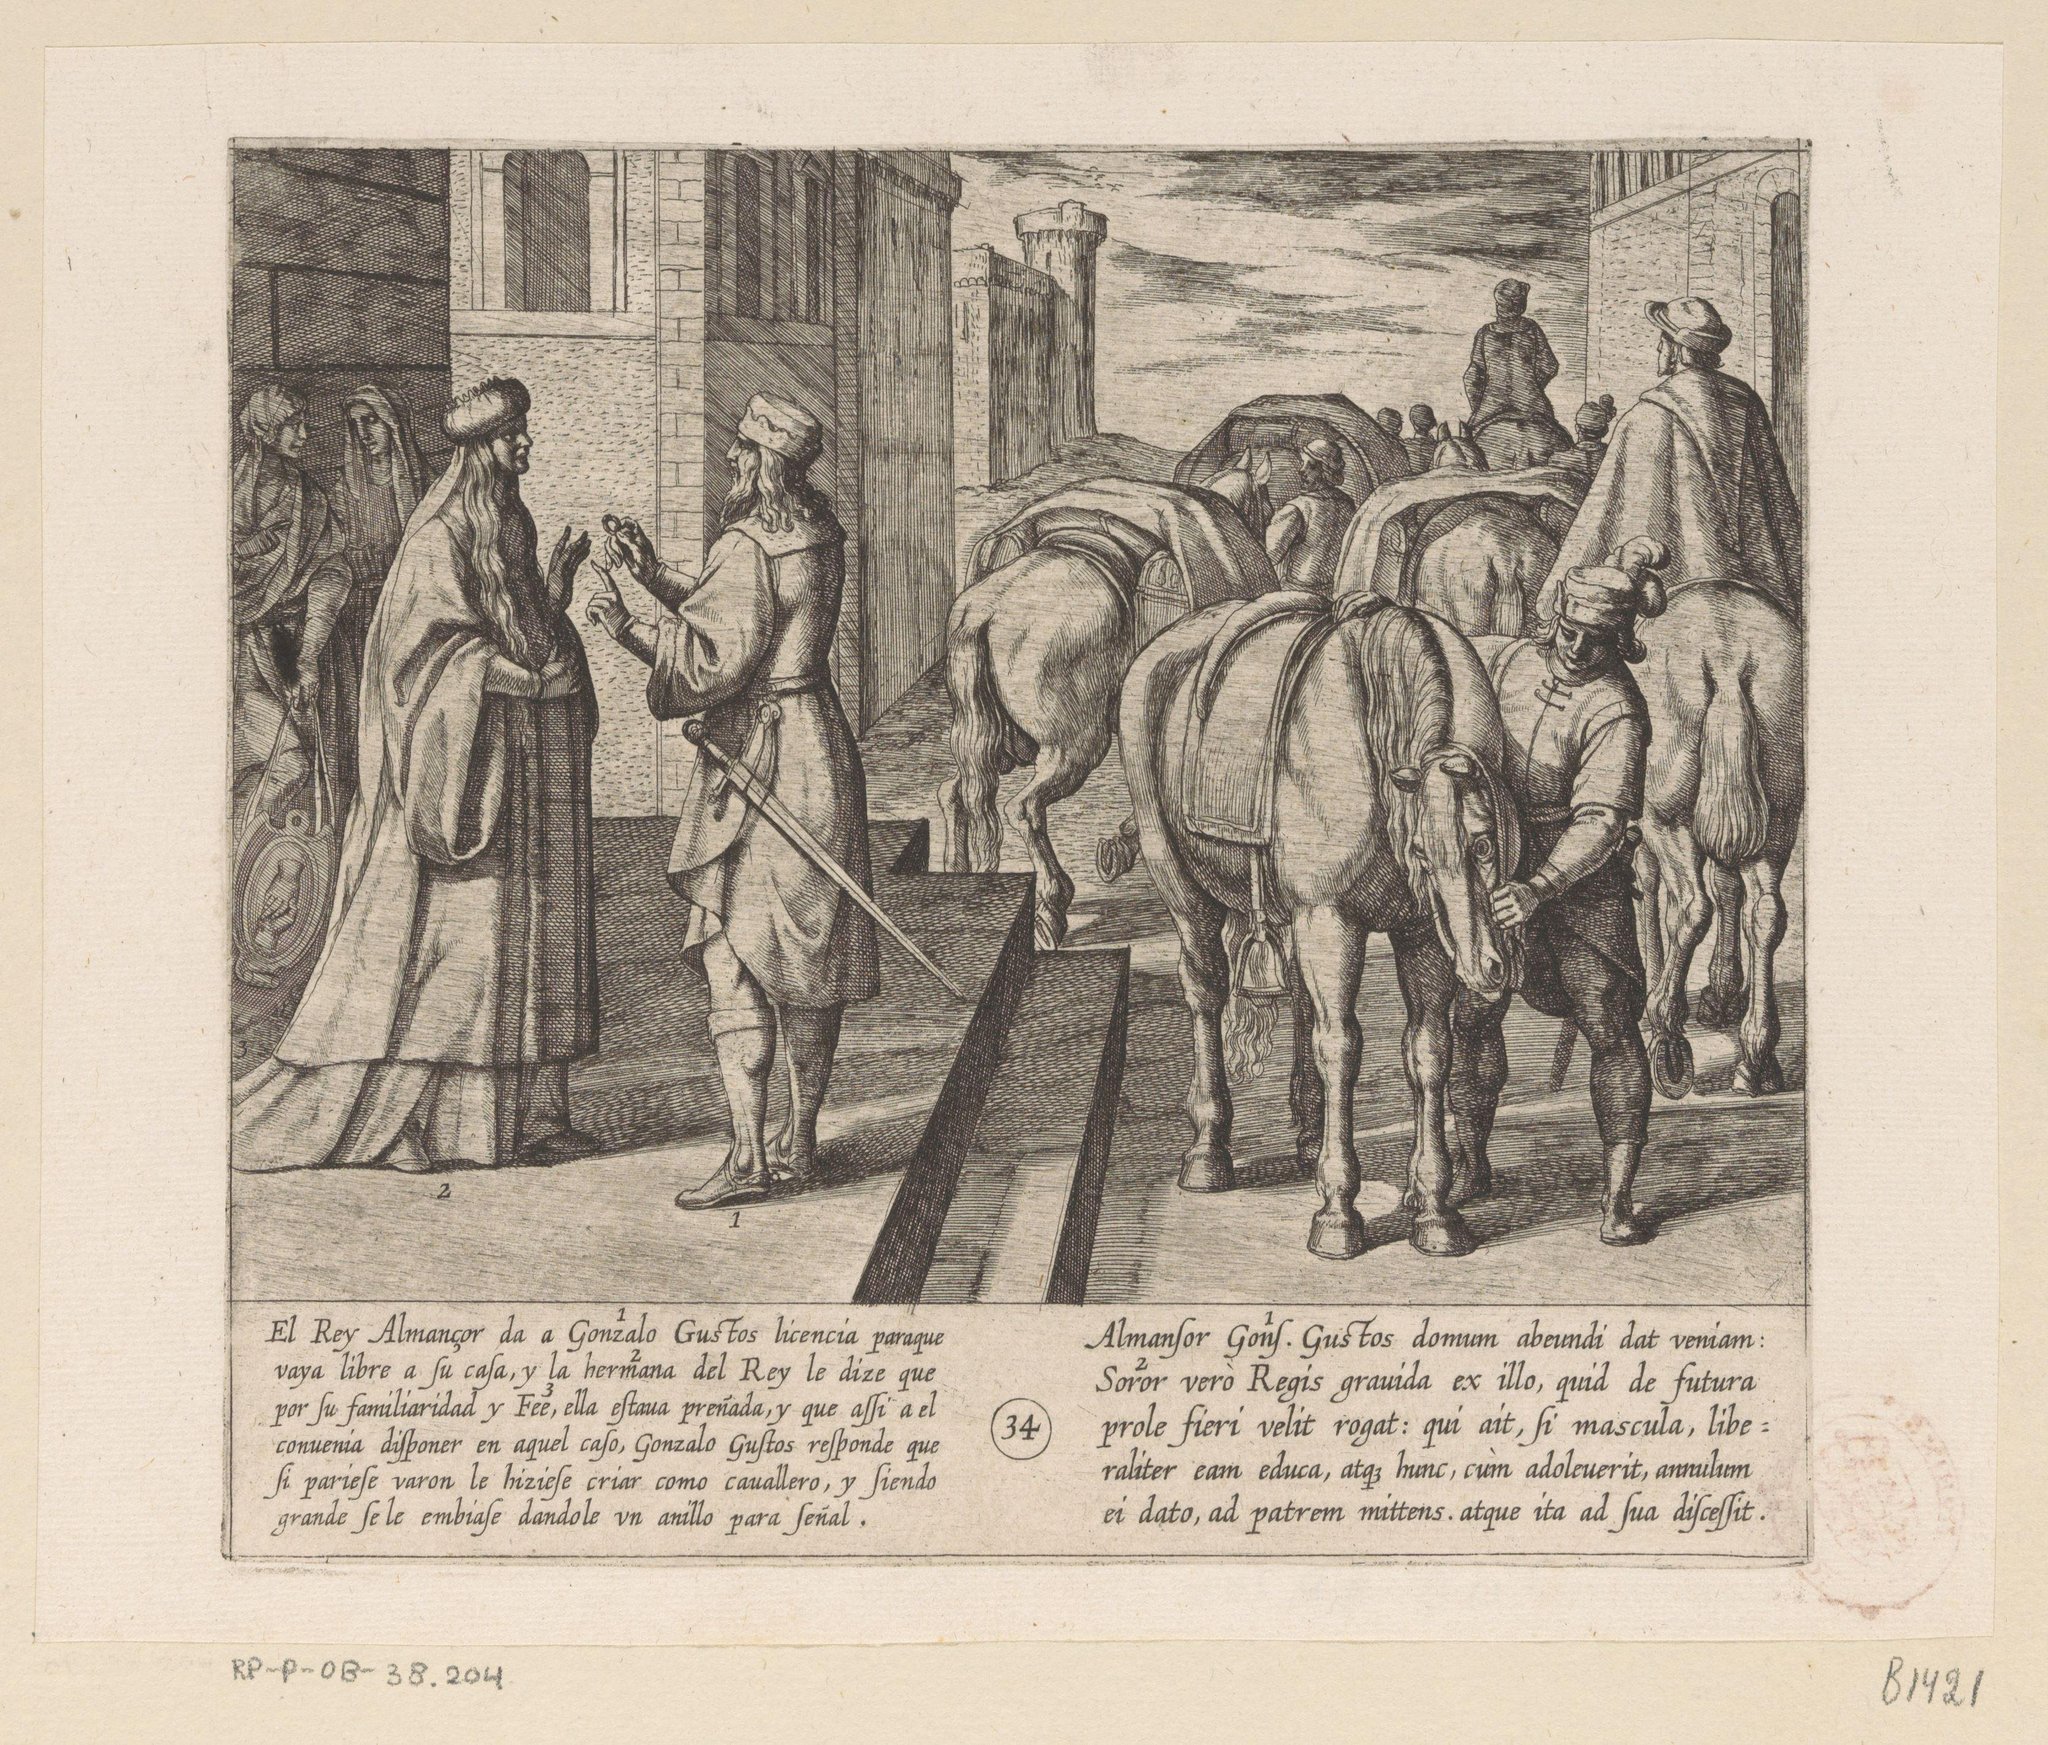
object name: print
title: De zeven infanten van Lara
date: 1612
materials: paper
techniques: etching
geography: italy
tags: riding a horse, ass, or mule; rider, horseman, tales and fairy tales, ring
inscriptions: collector's mark: Lugt 240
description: Deze prent maakt deel uit van een reeks van 40 prenten (+ titelprent) met voorstellingen uit het volksverhaal over de zeven infanten van Lara.